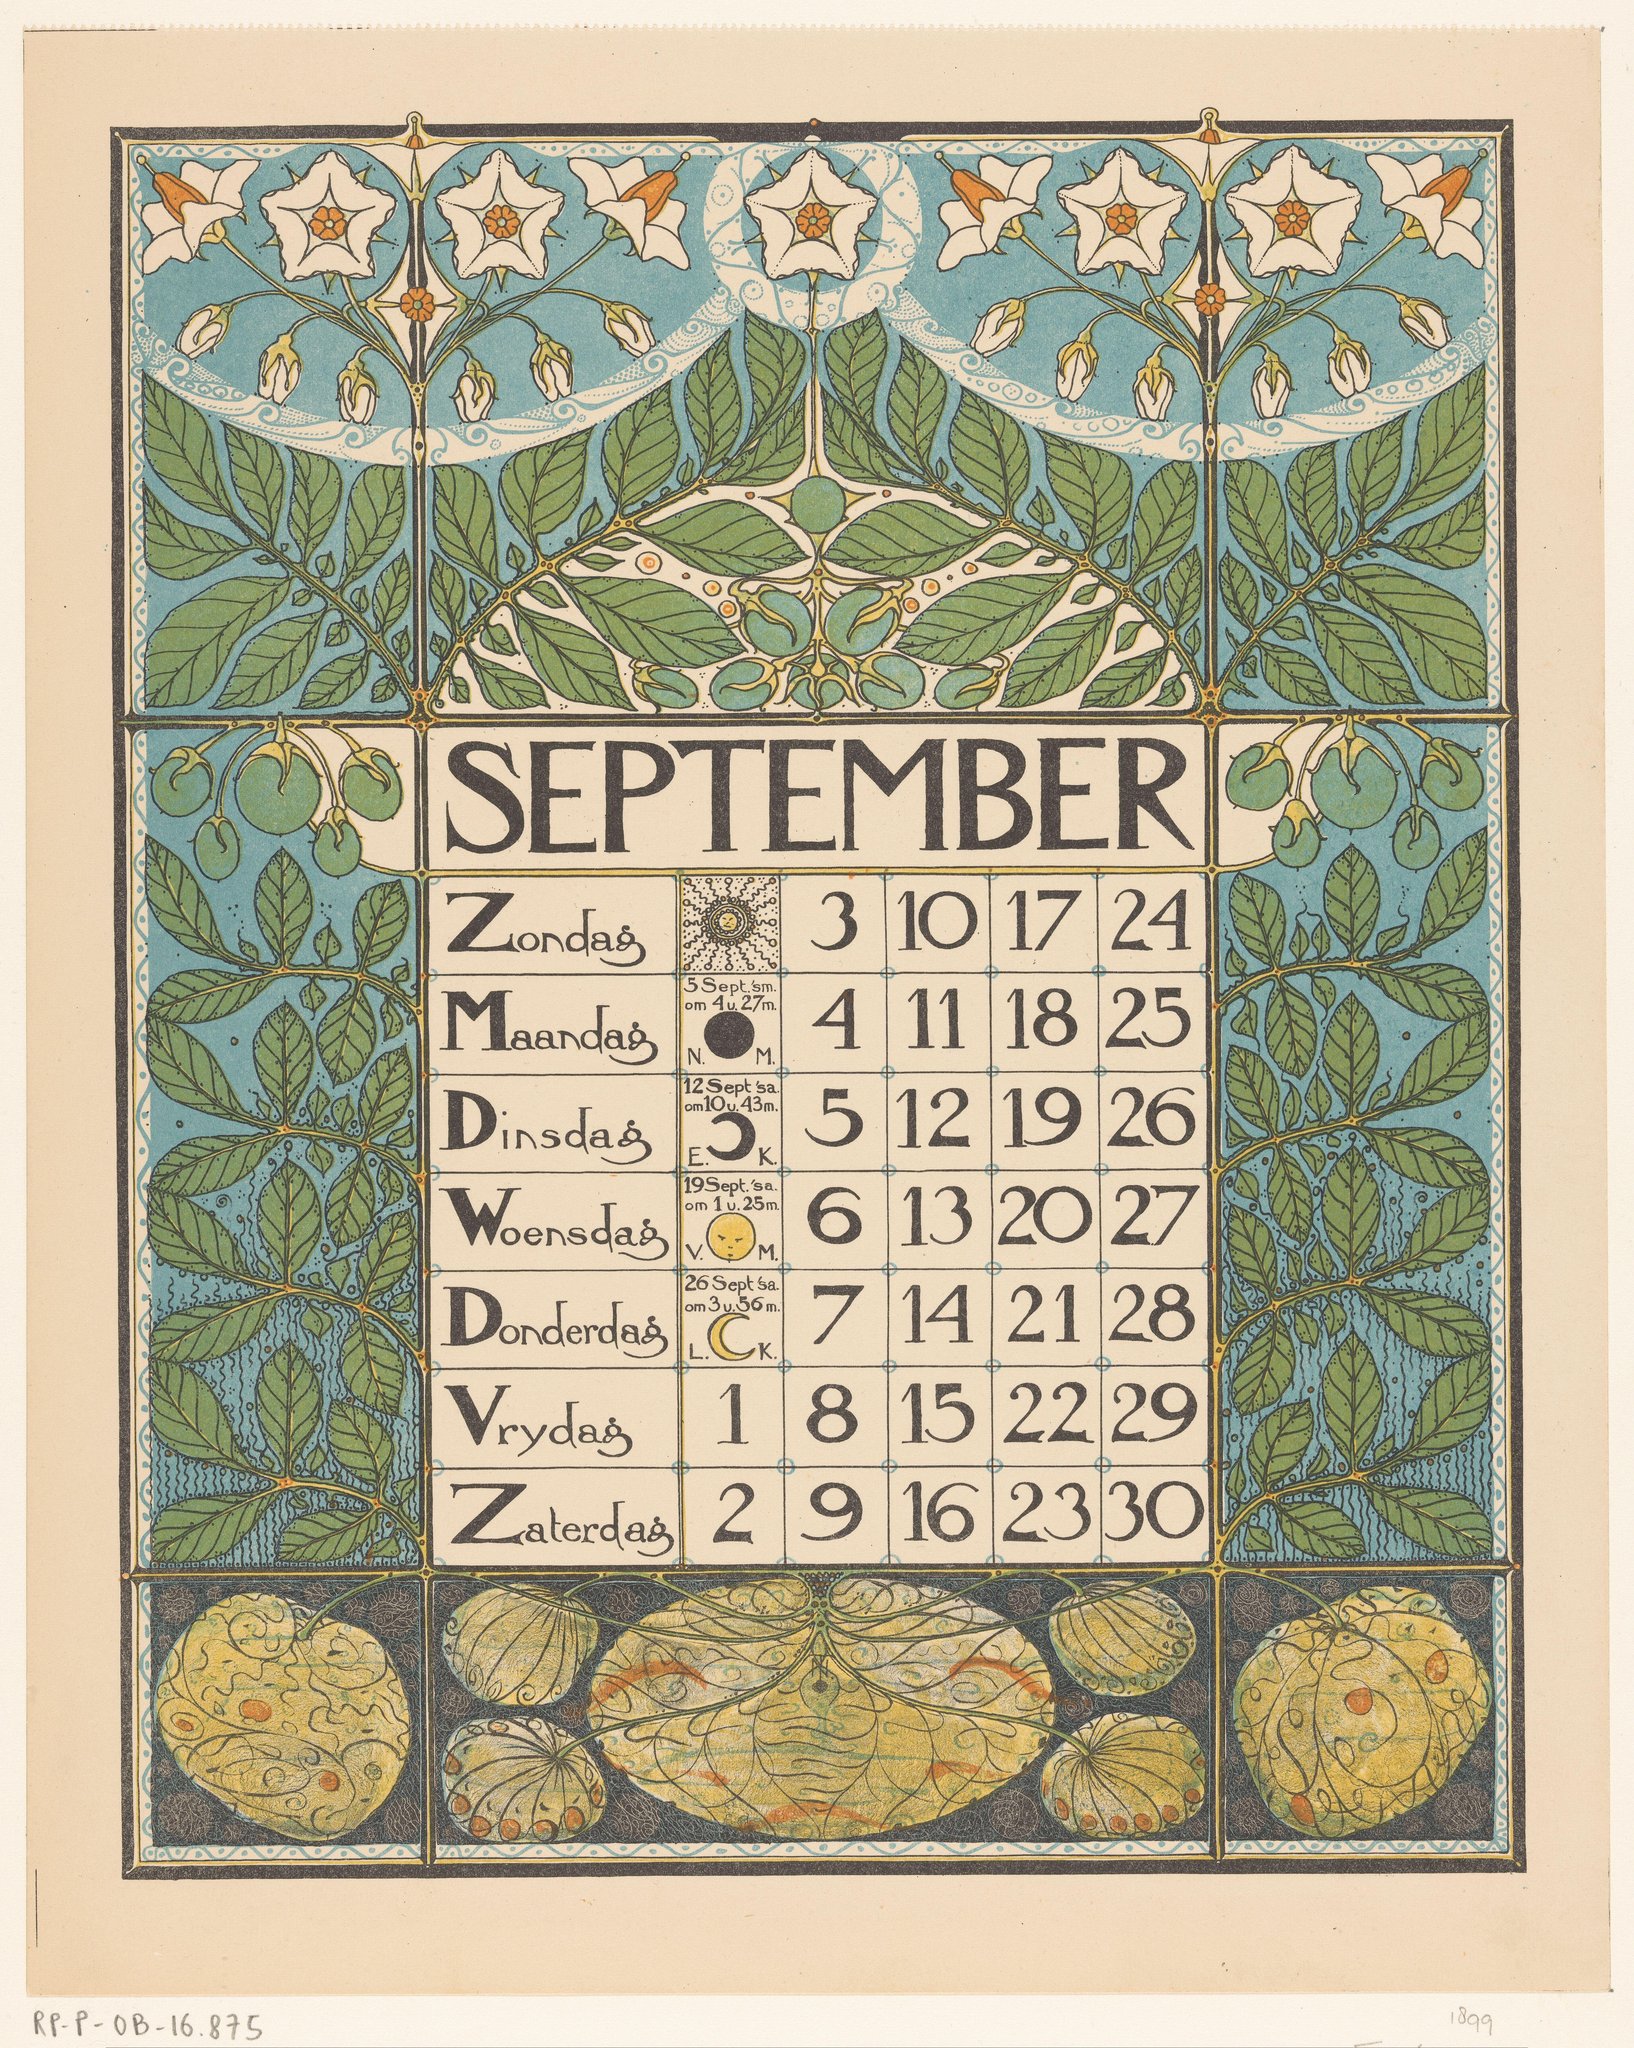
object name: calendar leaf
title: Kalenderblad voor september 1899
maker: theo nieuwenhuis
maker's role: designer, draughtsman, print maker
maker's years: 1866-1951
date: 1898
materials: paper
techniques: lithograph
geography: amsterdam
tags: flowers, ornament derived from plant forms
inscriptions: collector's mark: Lugt 2228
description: In 1898 vervaardigden Gerrit Willem Dijsselhof, Carel Adolph Lion Cachet en Theo Nieuwenhuis samen een kalender voor het jaar 1899. Nieuwenhuis nam het ontwerp van de maanden maart, juni, september en december op zich.